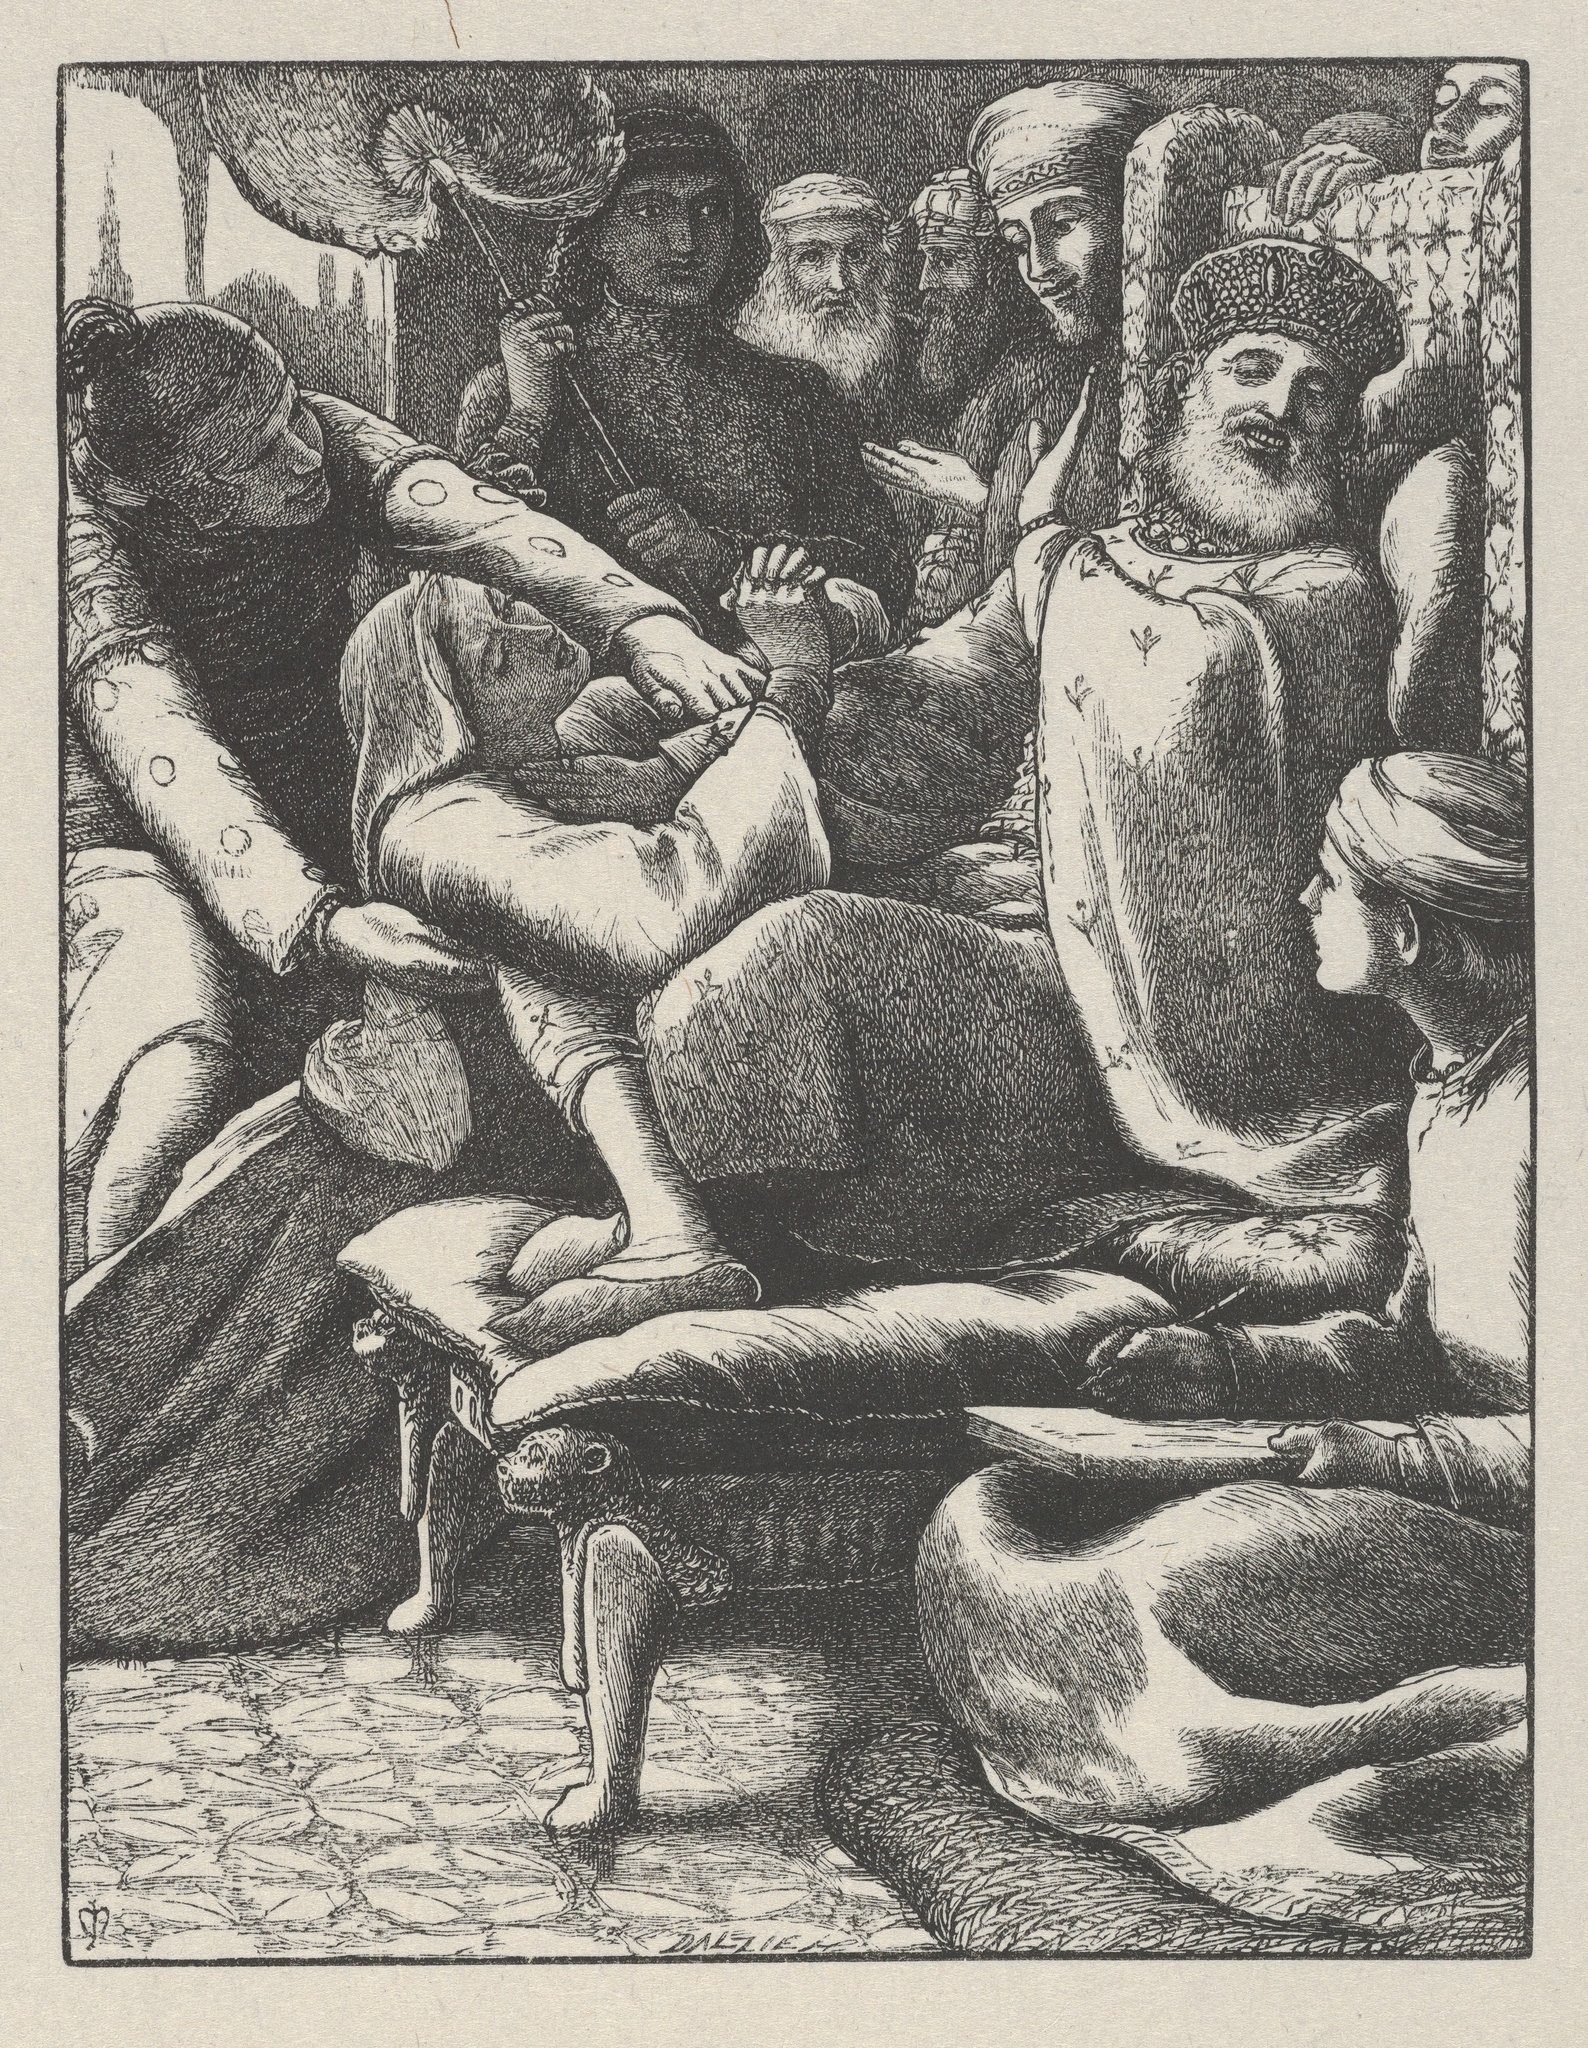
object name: print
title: The Unjust Judge and the Importunate Widow (The Parables of Our Lord and Saviour Jesus Christ)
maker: sir john everett millais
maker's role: artist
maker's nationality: british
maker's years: 1829-1896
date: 1864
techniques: engraving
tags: men,women